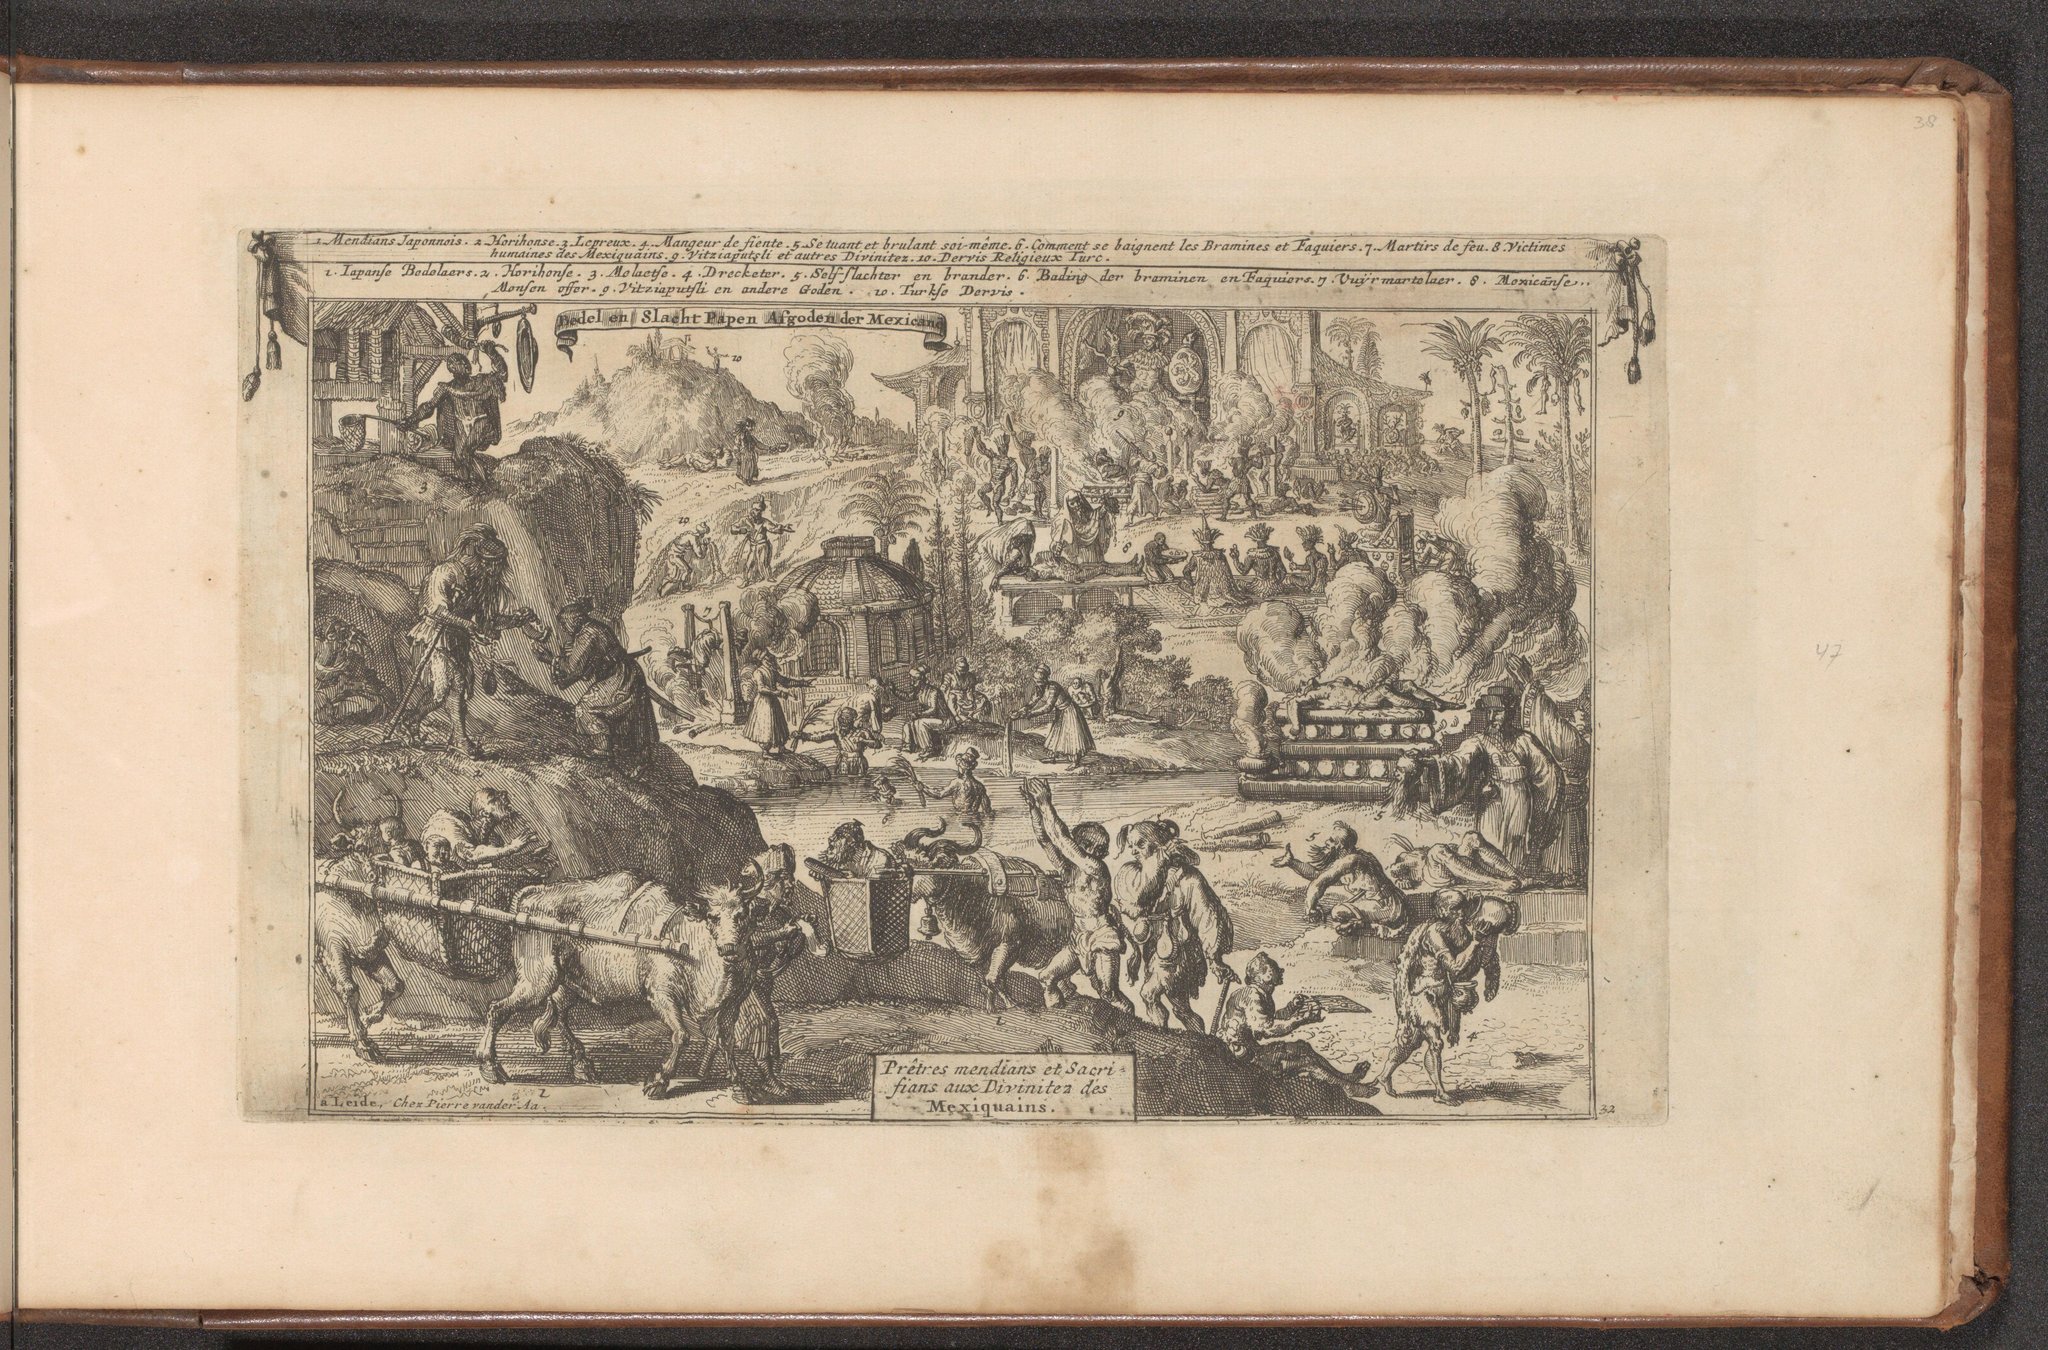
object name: album leaf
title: Bedelaars in Oost- en West-Indië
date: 1682-1733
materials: paper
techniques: etching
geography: leiden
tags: mutilation of the corpse, beggar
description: Landschap met bedelaars die voornamelijk door het opwekken van medelijden mensen proberen te bewegen een aalmoes te geven. Ze dreigen zichzelf iets aan te doen. Zo steekt rechts een man zichzelf in de borst. Een ander man bekleed met een tijgerhuid drinkt drek uit een pot. Een andere man heeft na een weigering zichzelf het hoofd afgesneden. Dit hoofd wordt daarna door een andere man aan het volk getoond. Op de voorgrond Japanse bedelaars. Oude mannen en kinderen worden gedragen in manden die met touwen en stokken aan ossen zijn gebonden. Met een legenda in het Nederlands en het Frans. De prent maakt deel uit van een album.